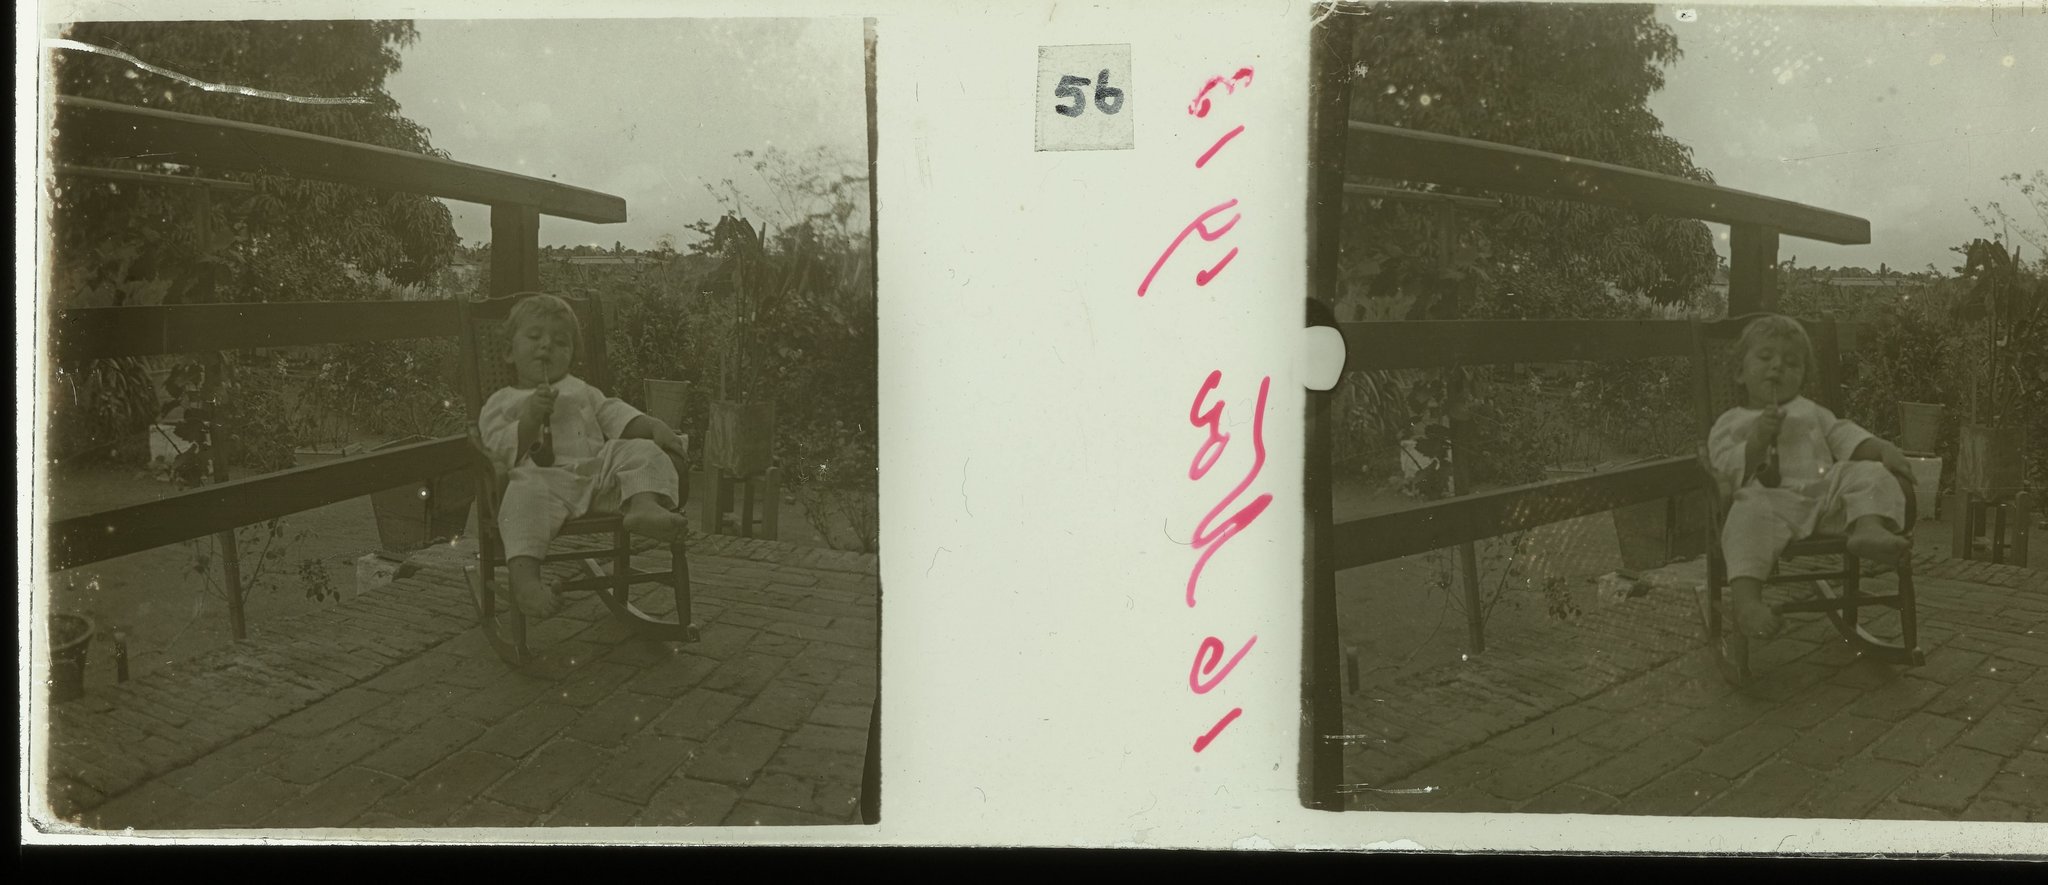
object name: stereograph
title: Gerard Brouwers op de veranda van Plantage Accaribo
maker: theodoor brouwers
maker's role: amateurfotograaf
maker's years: 1874-1932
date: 1913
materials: glass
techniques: photography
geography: suriname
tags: theodoor brouwers, plantation, suriname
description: In de periode 1911-1932 woonde op plantage Accaribo in Suriname de familie Brouwers van wie de foto's afkomstig zijn. Rond 1910 vond Theodoor Brouwers werk op plantage Accaribo. In 1929 werd hij eigenaar van de plantage. Op Accaribo werden in zijn tijd bananen geproduceerd en wat koffie.